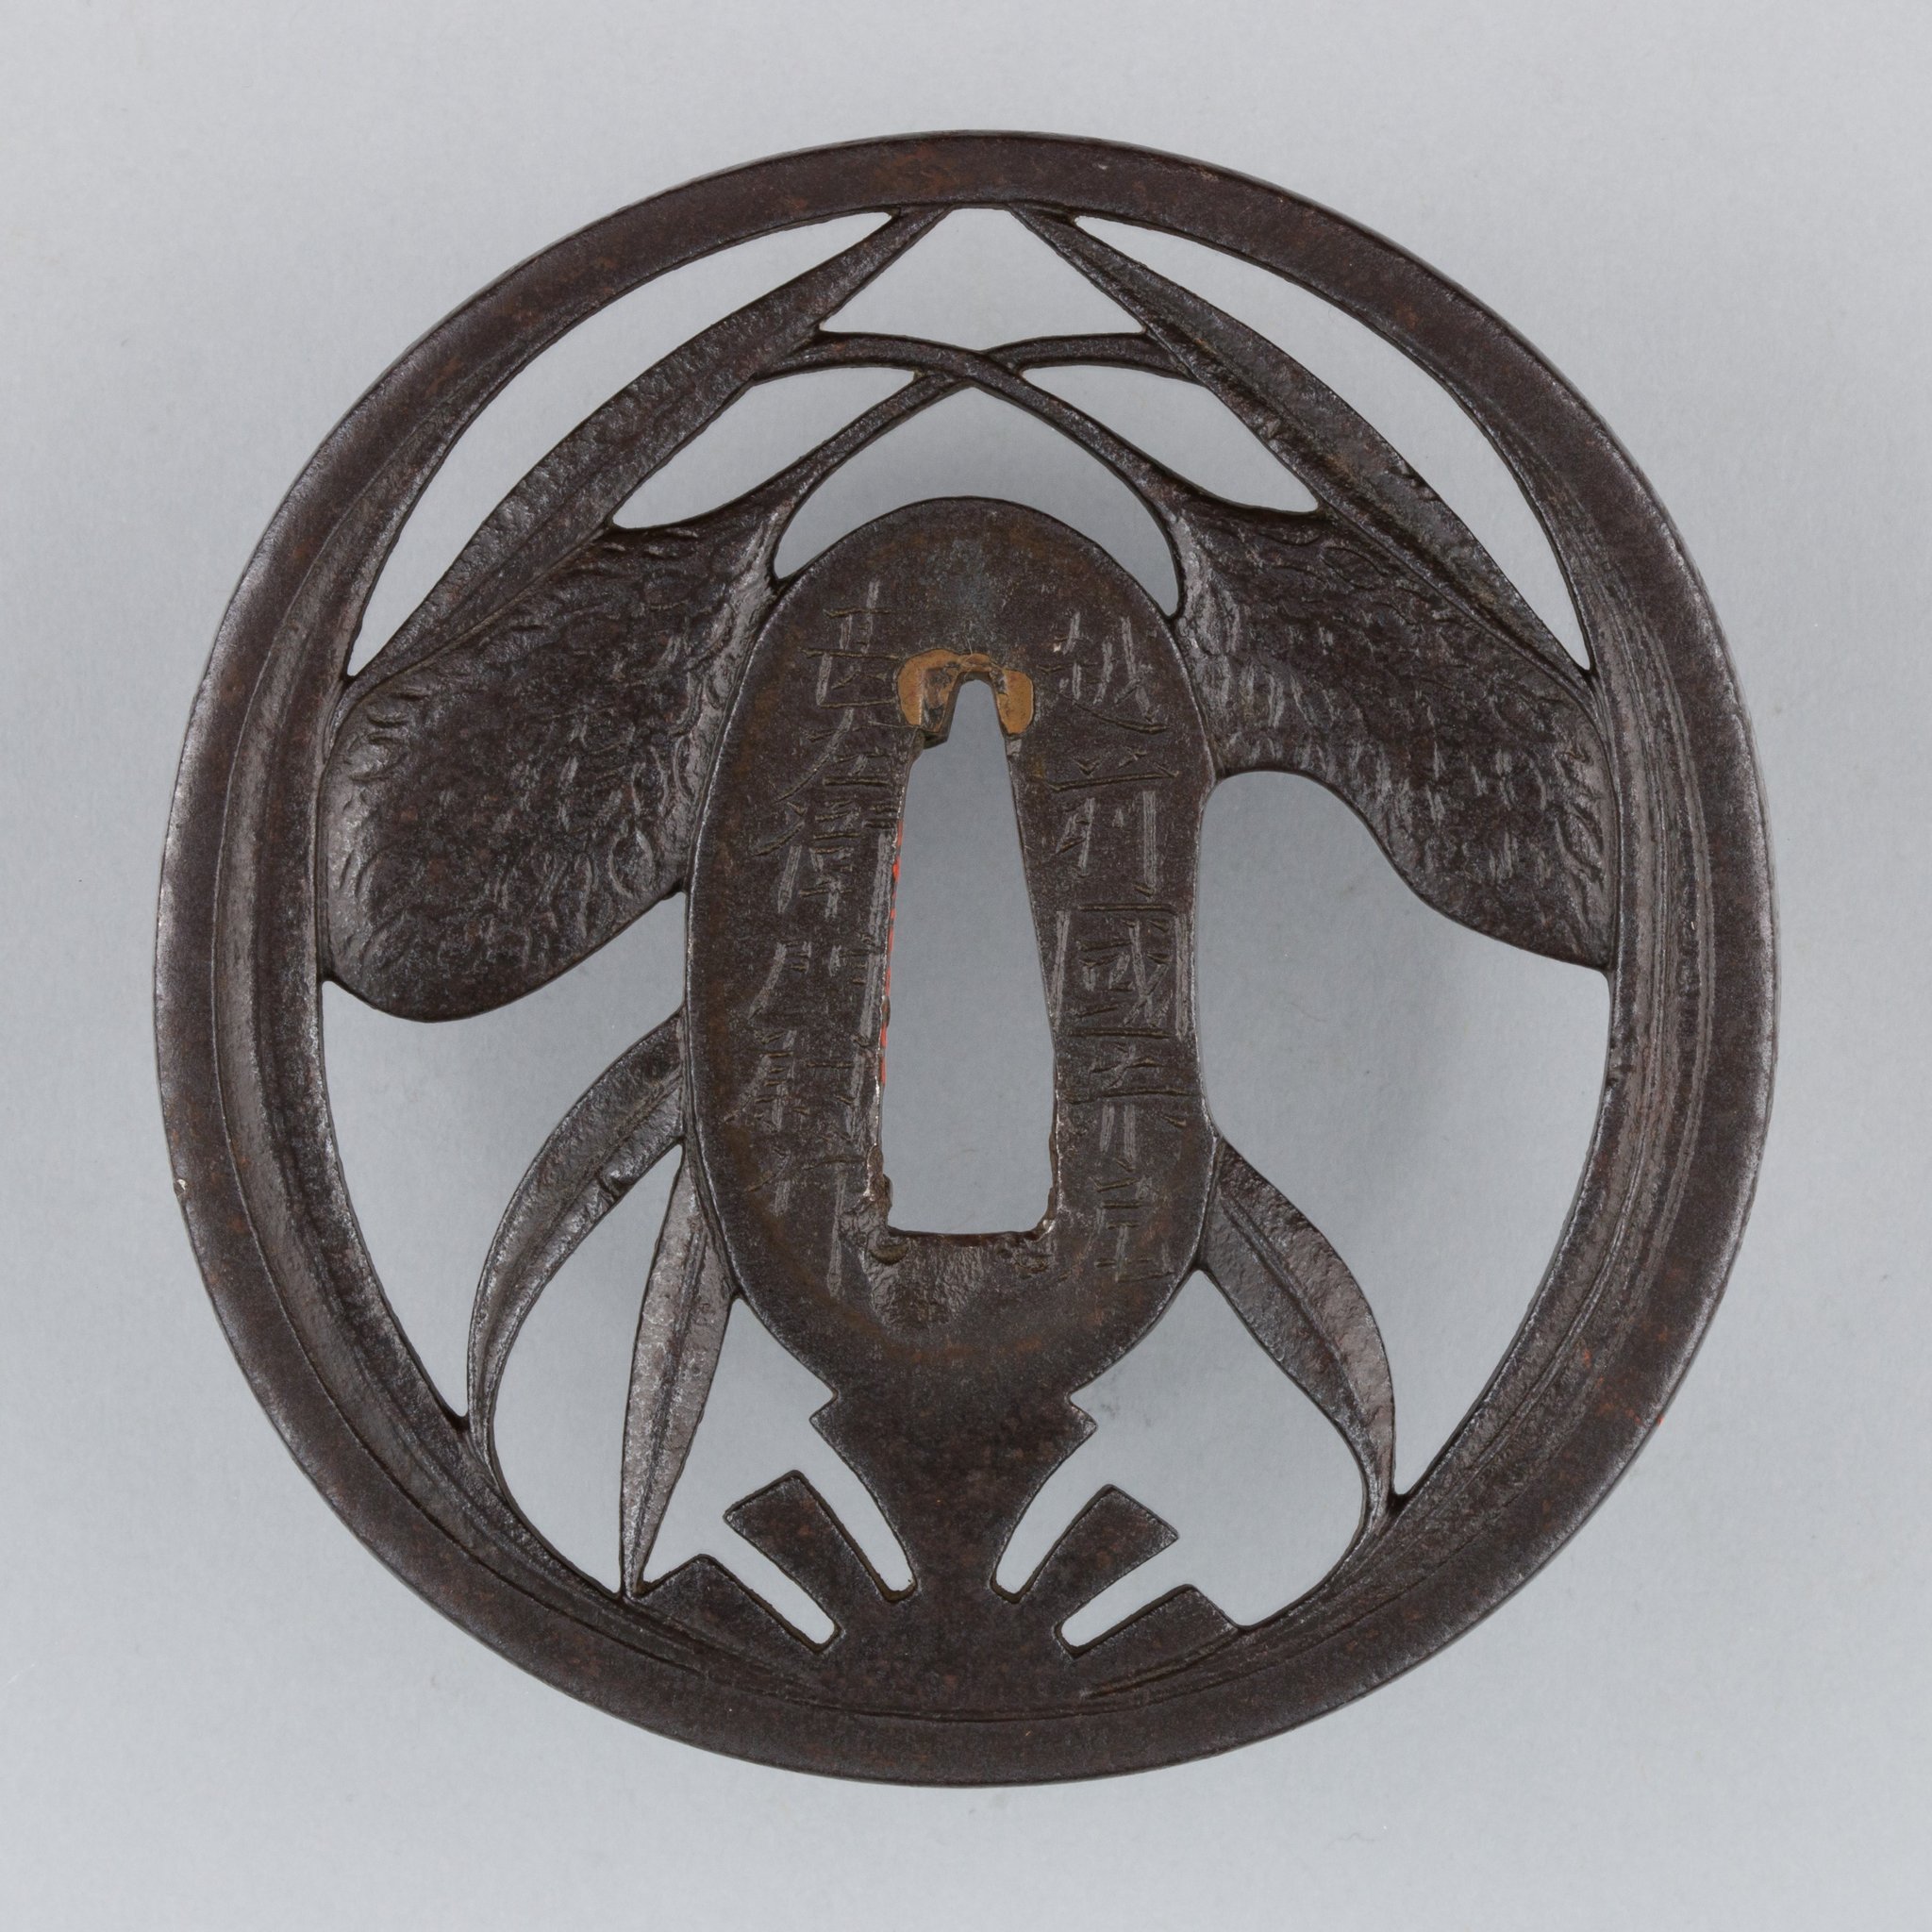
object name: sword guard tsuba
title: Sword Guard (Tsuba)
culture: japanese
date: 1701-1750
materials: copper, iron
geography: japan